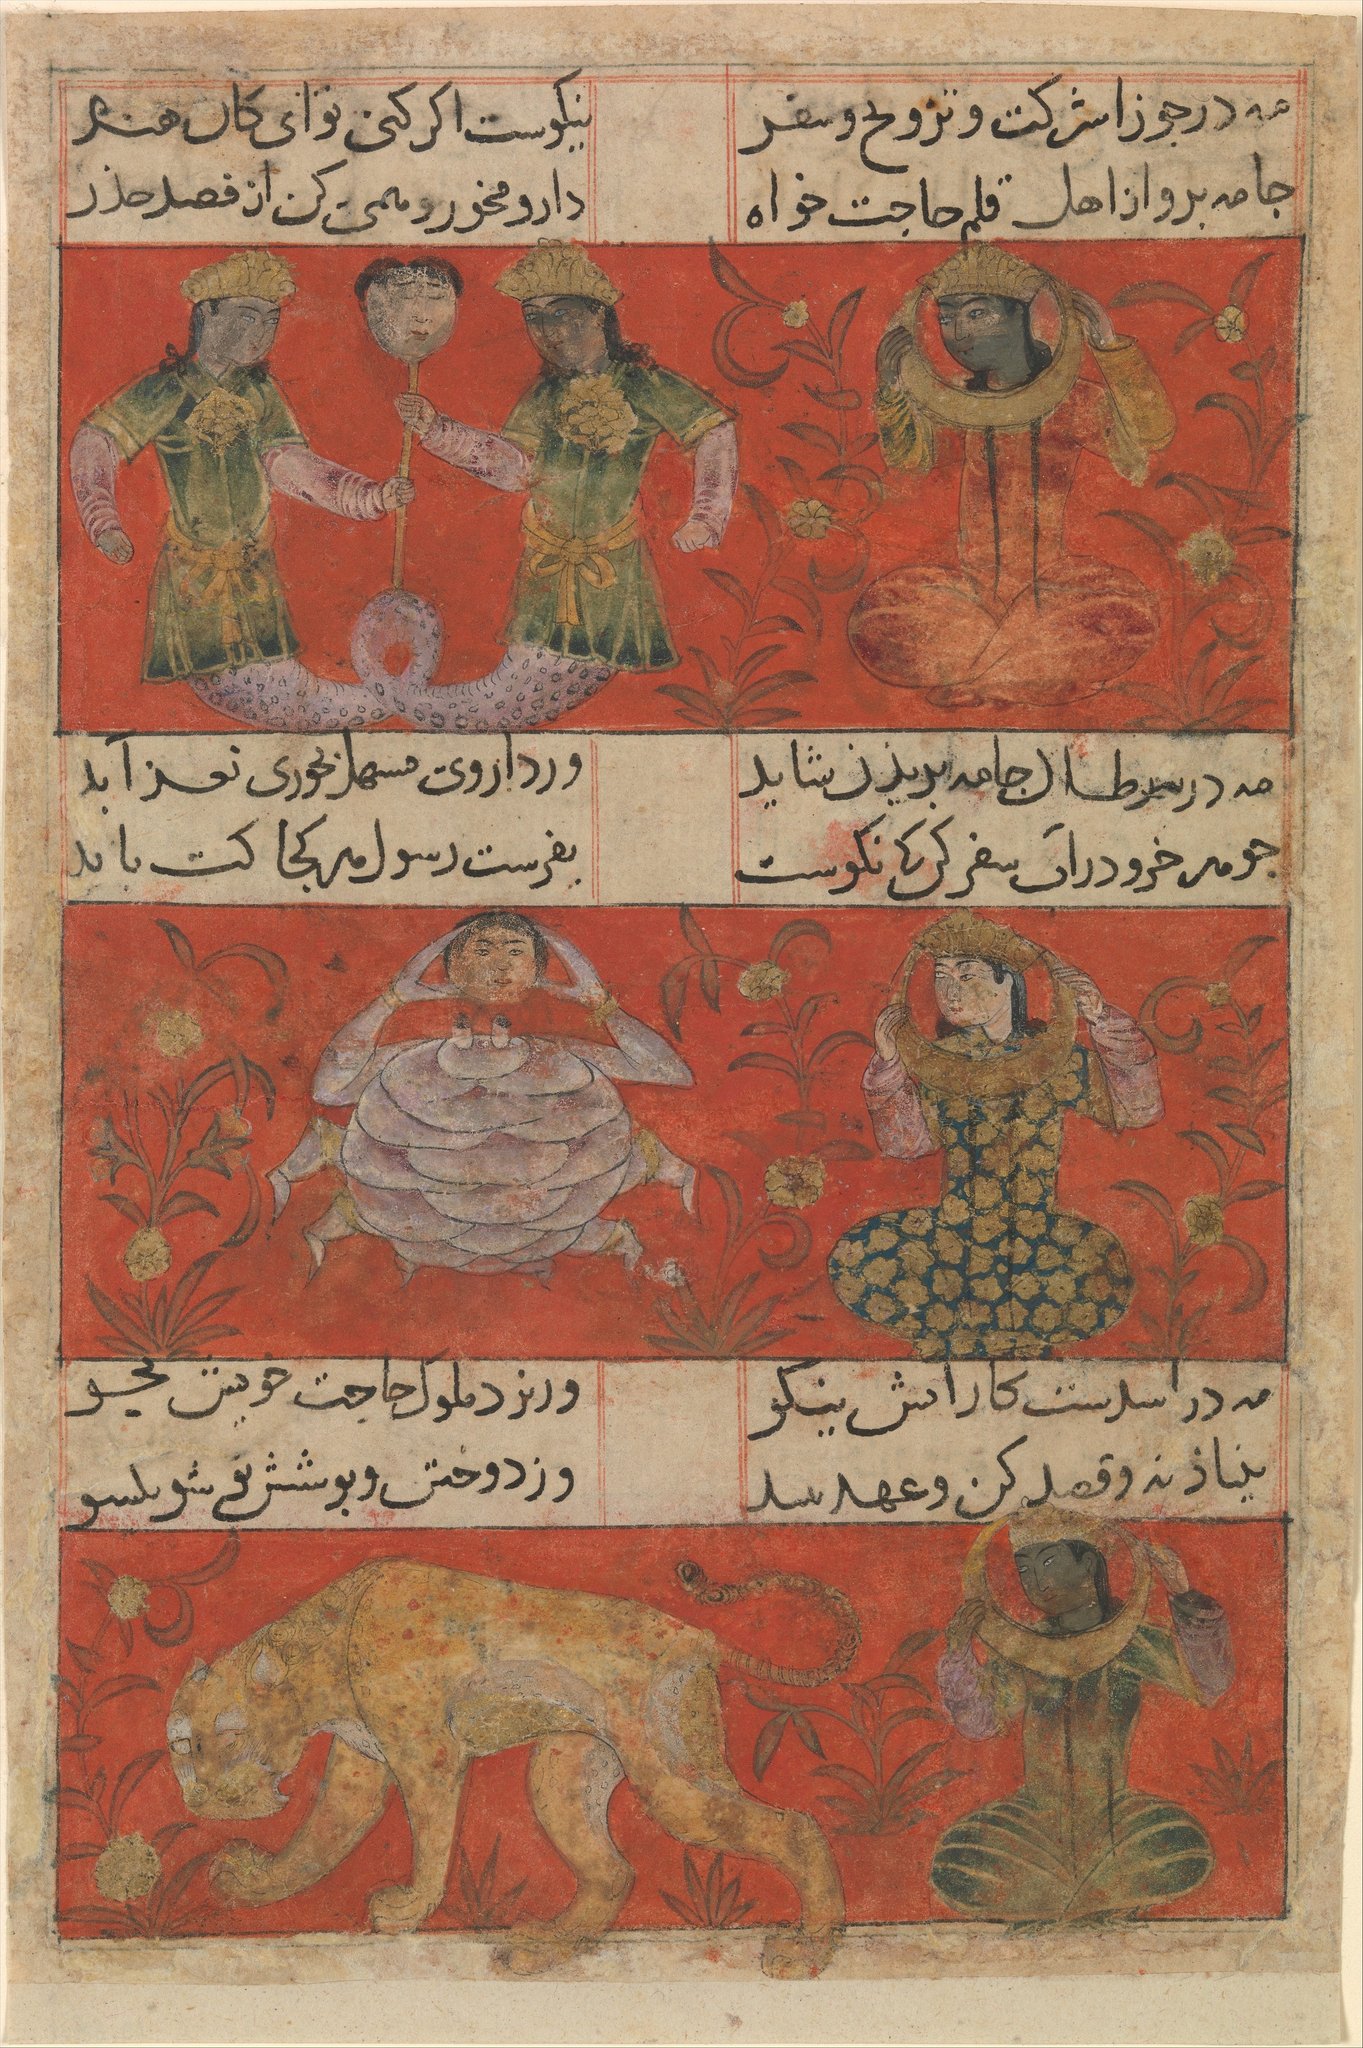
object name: folio from an illustrated manuscript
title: Folio from a Mu'nis al-ahrar fi daqa'iq al-ash'ar (The Free Man's Companion to the Subtleties of Poems) of Jajarmi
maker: muhammad ibn badr al-din jajarmi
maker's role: author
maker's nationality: iranian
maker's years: 1315-1365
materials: gold, ink, paper, watercolor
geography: iran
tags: poetry,bulls,crabs,lions,rams,zodiac